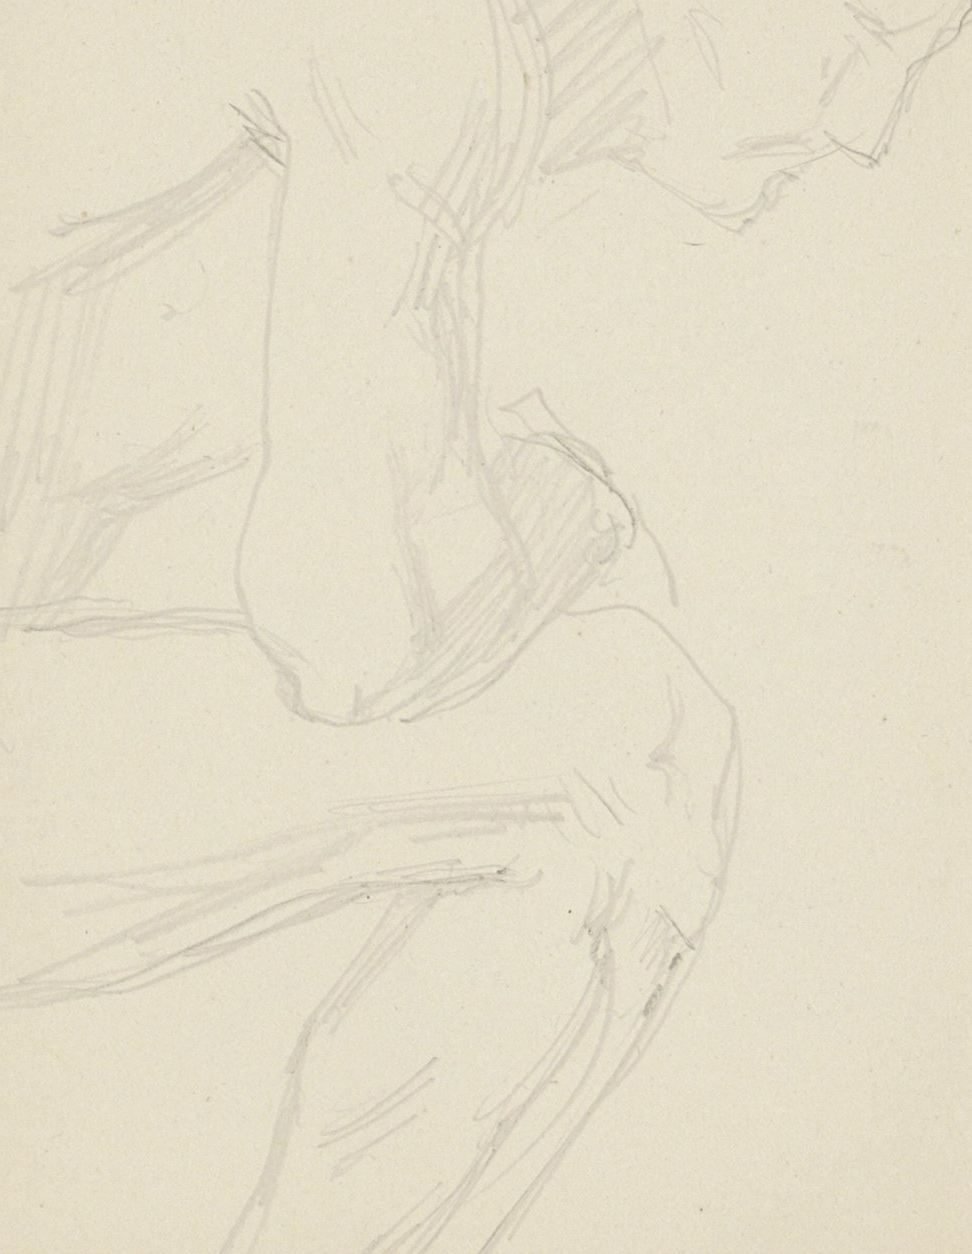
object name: sketchbook leaf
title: Naakte man, knielend op één knie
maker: reijer stolk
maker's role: draughtsman, print maker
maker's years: 1896-1945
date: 1906-1945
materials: paper, pencil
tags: kneeling figure (+ nude human being)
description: Blad 54 verso uit een schetsboek met 69 bladen.